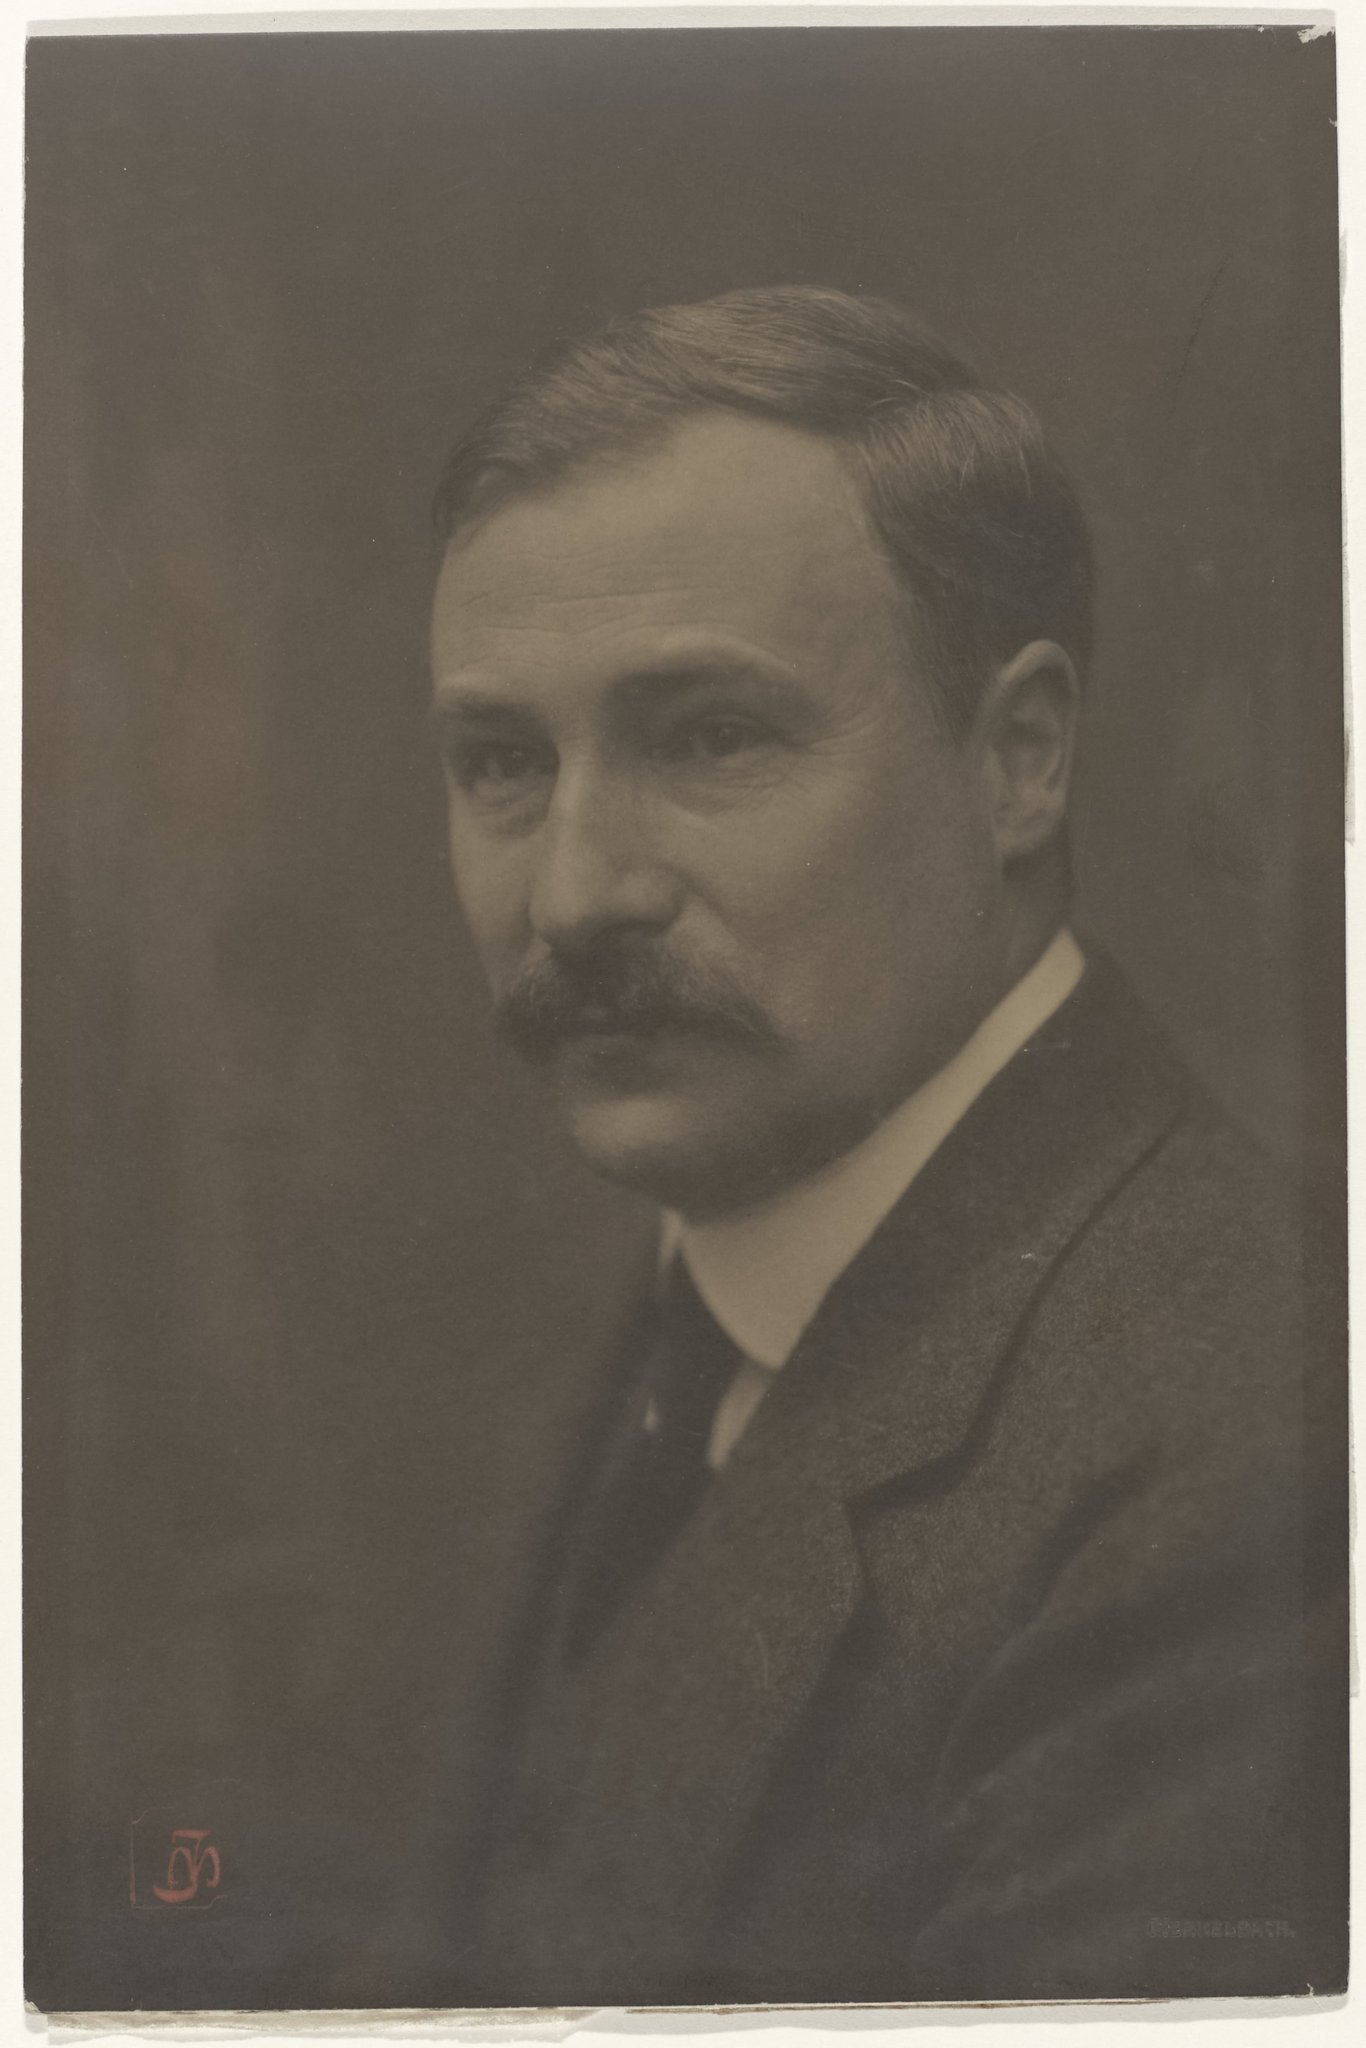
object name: photograph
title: Portret van C.A. den Tex, directeur van de Stoomvaartmaatschappij Nederland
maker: jacob merkelbach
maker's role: fotograaf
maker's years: 1877-1942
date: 1920-1930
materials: cardboard, photographic support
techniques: platinum process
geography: amsterdam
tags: historical persons (portraits and scenes from the life)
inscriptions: check stamp: ‘Merkelbach’, signature: ‘JM’, inscription: ‘Den Tra’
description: Portret van C.A. den Tex, directeur van de Stoomvaartmaatschappij Nederland